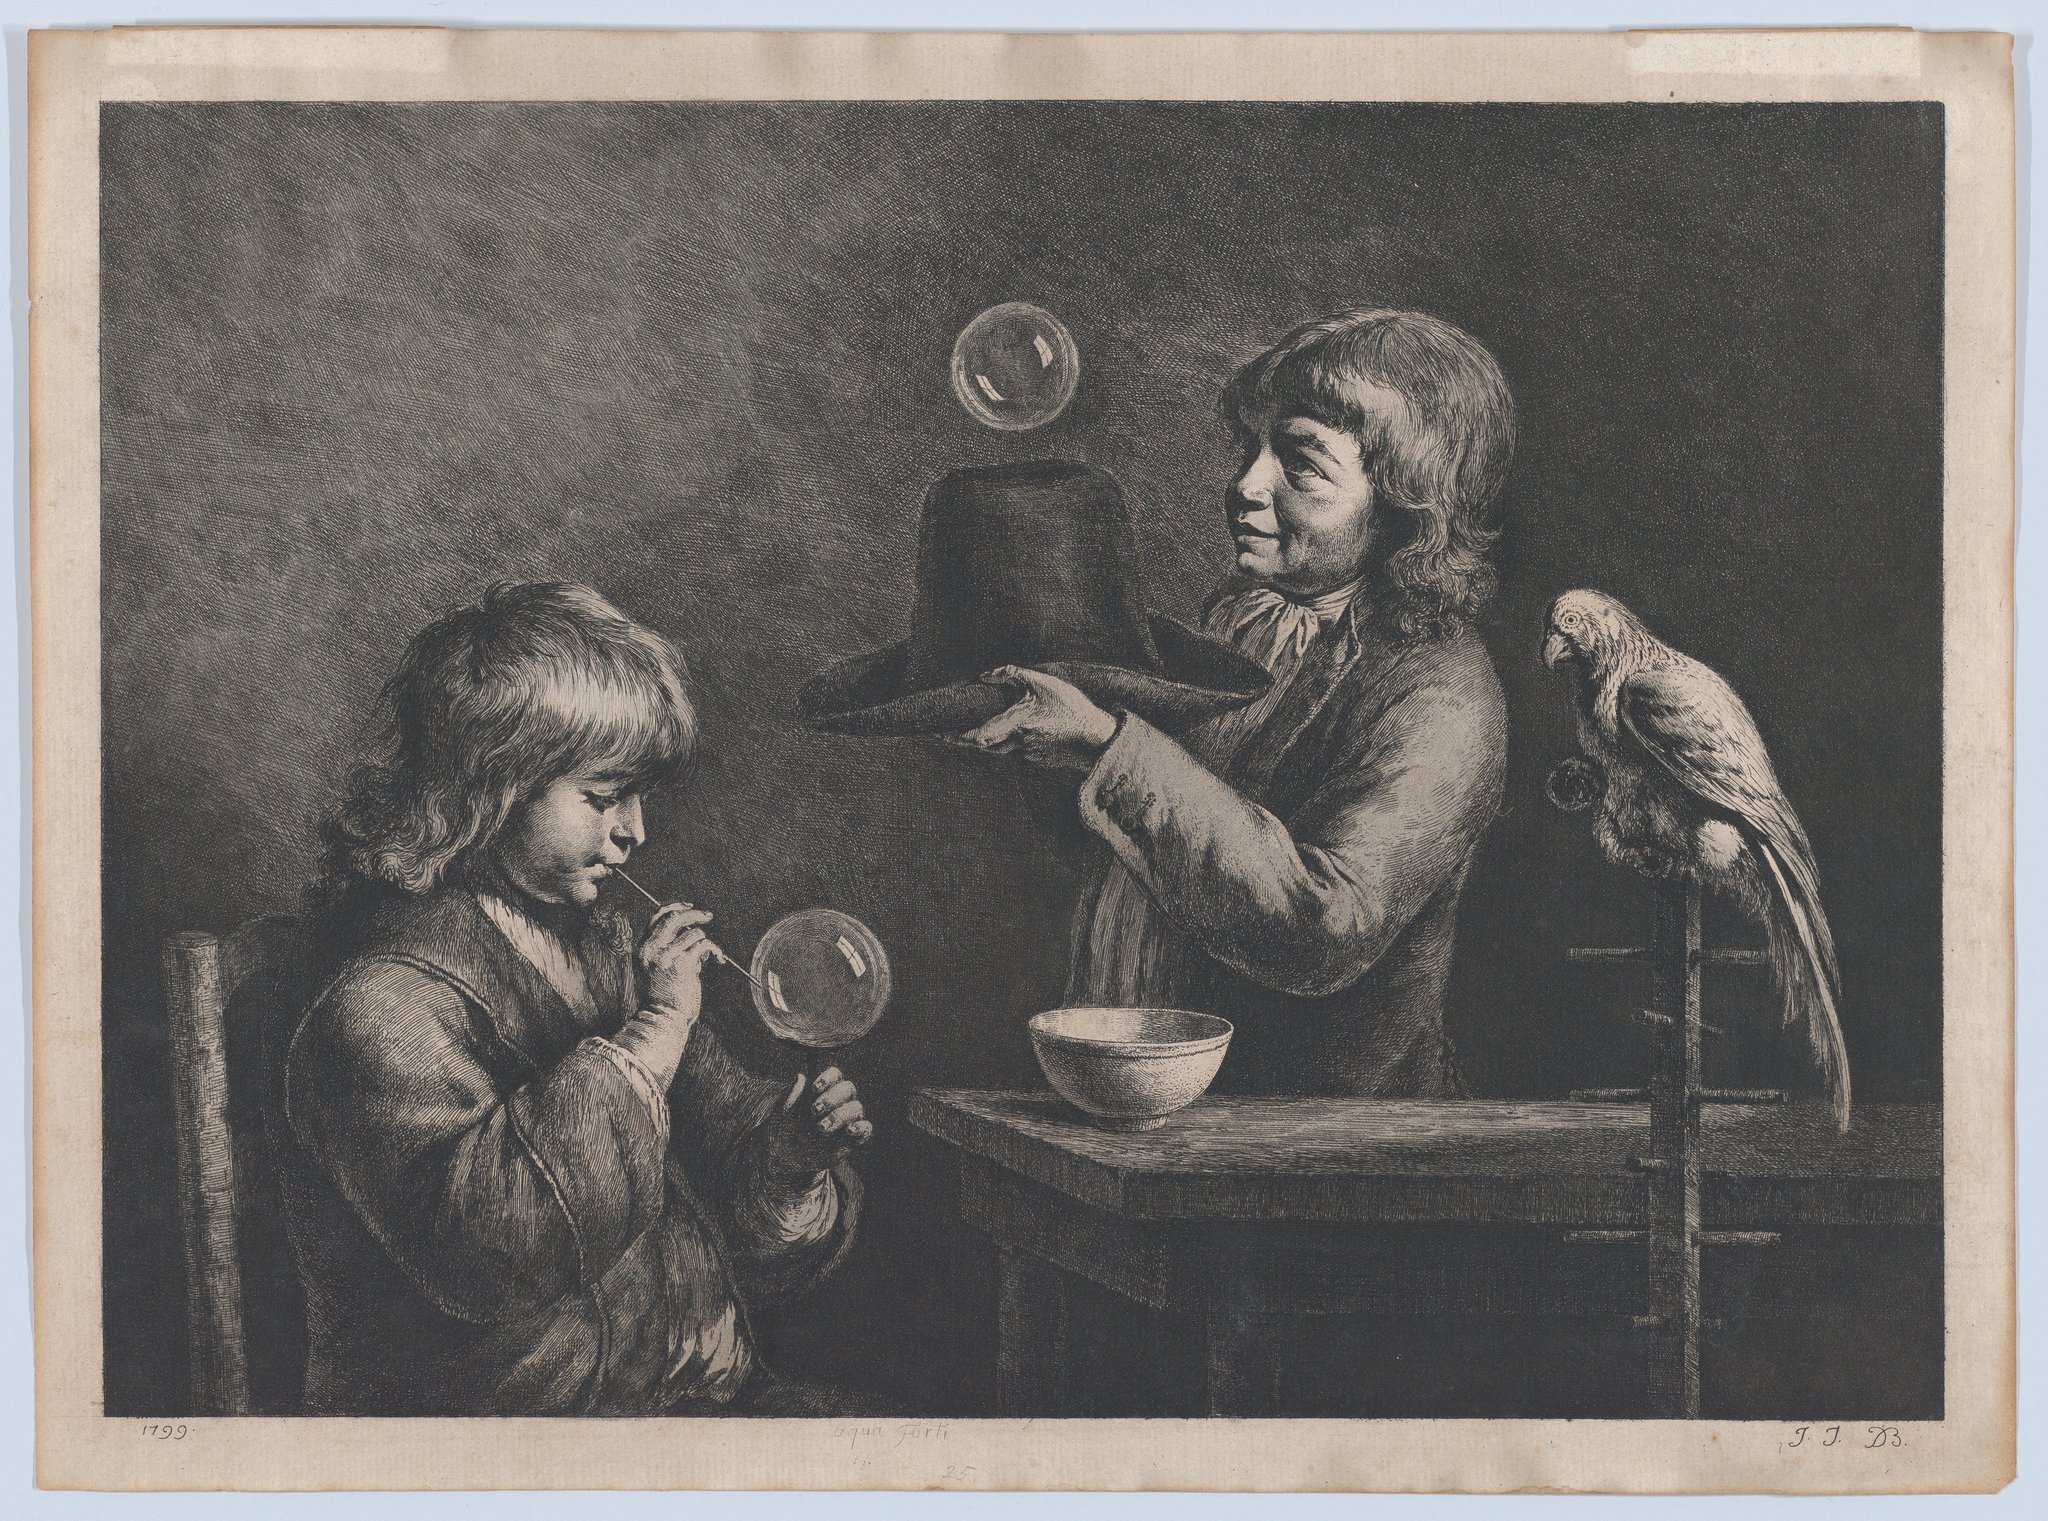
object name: print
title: Soap Bubbles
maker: jean jacques de boissieu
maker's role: artist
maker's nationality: french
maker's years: 1736-1810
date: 1799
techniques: engraving, drypoint, etching, roulette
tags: birds,hats,boys,bubbles,bowls